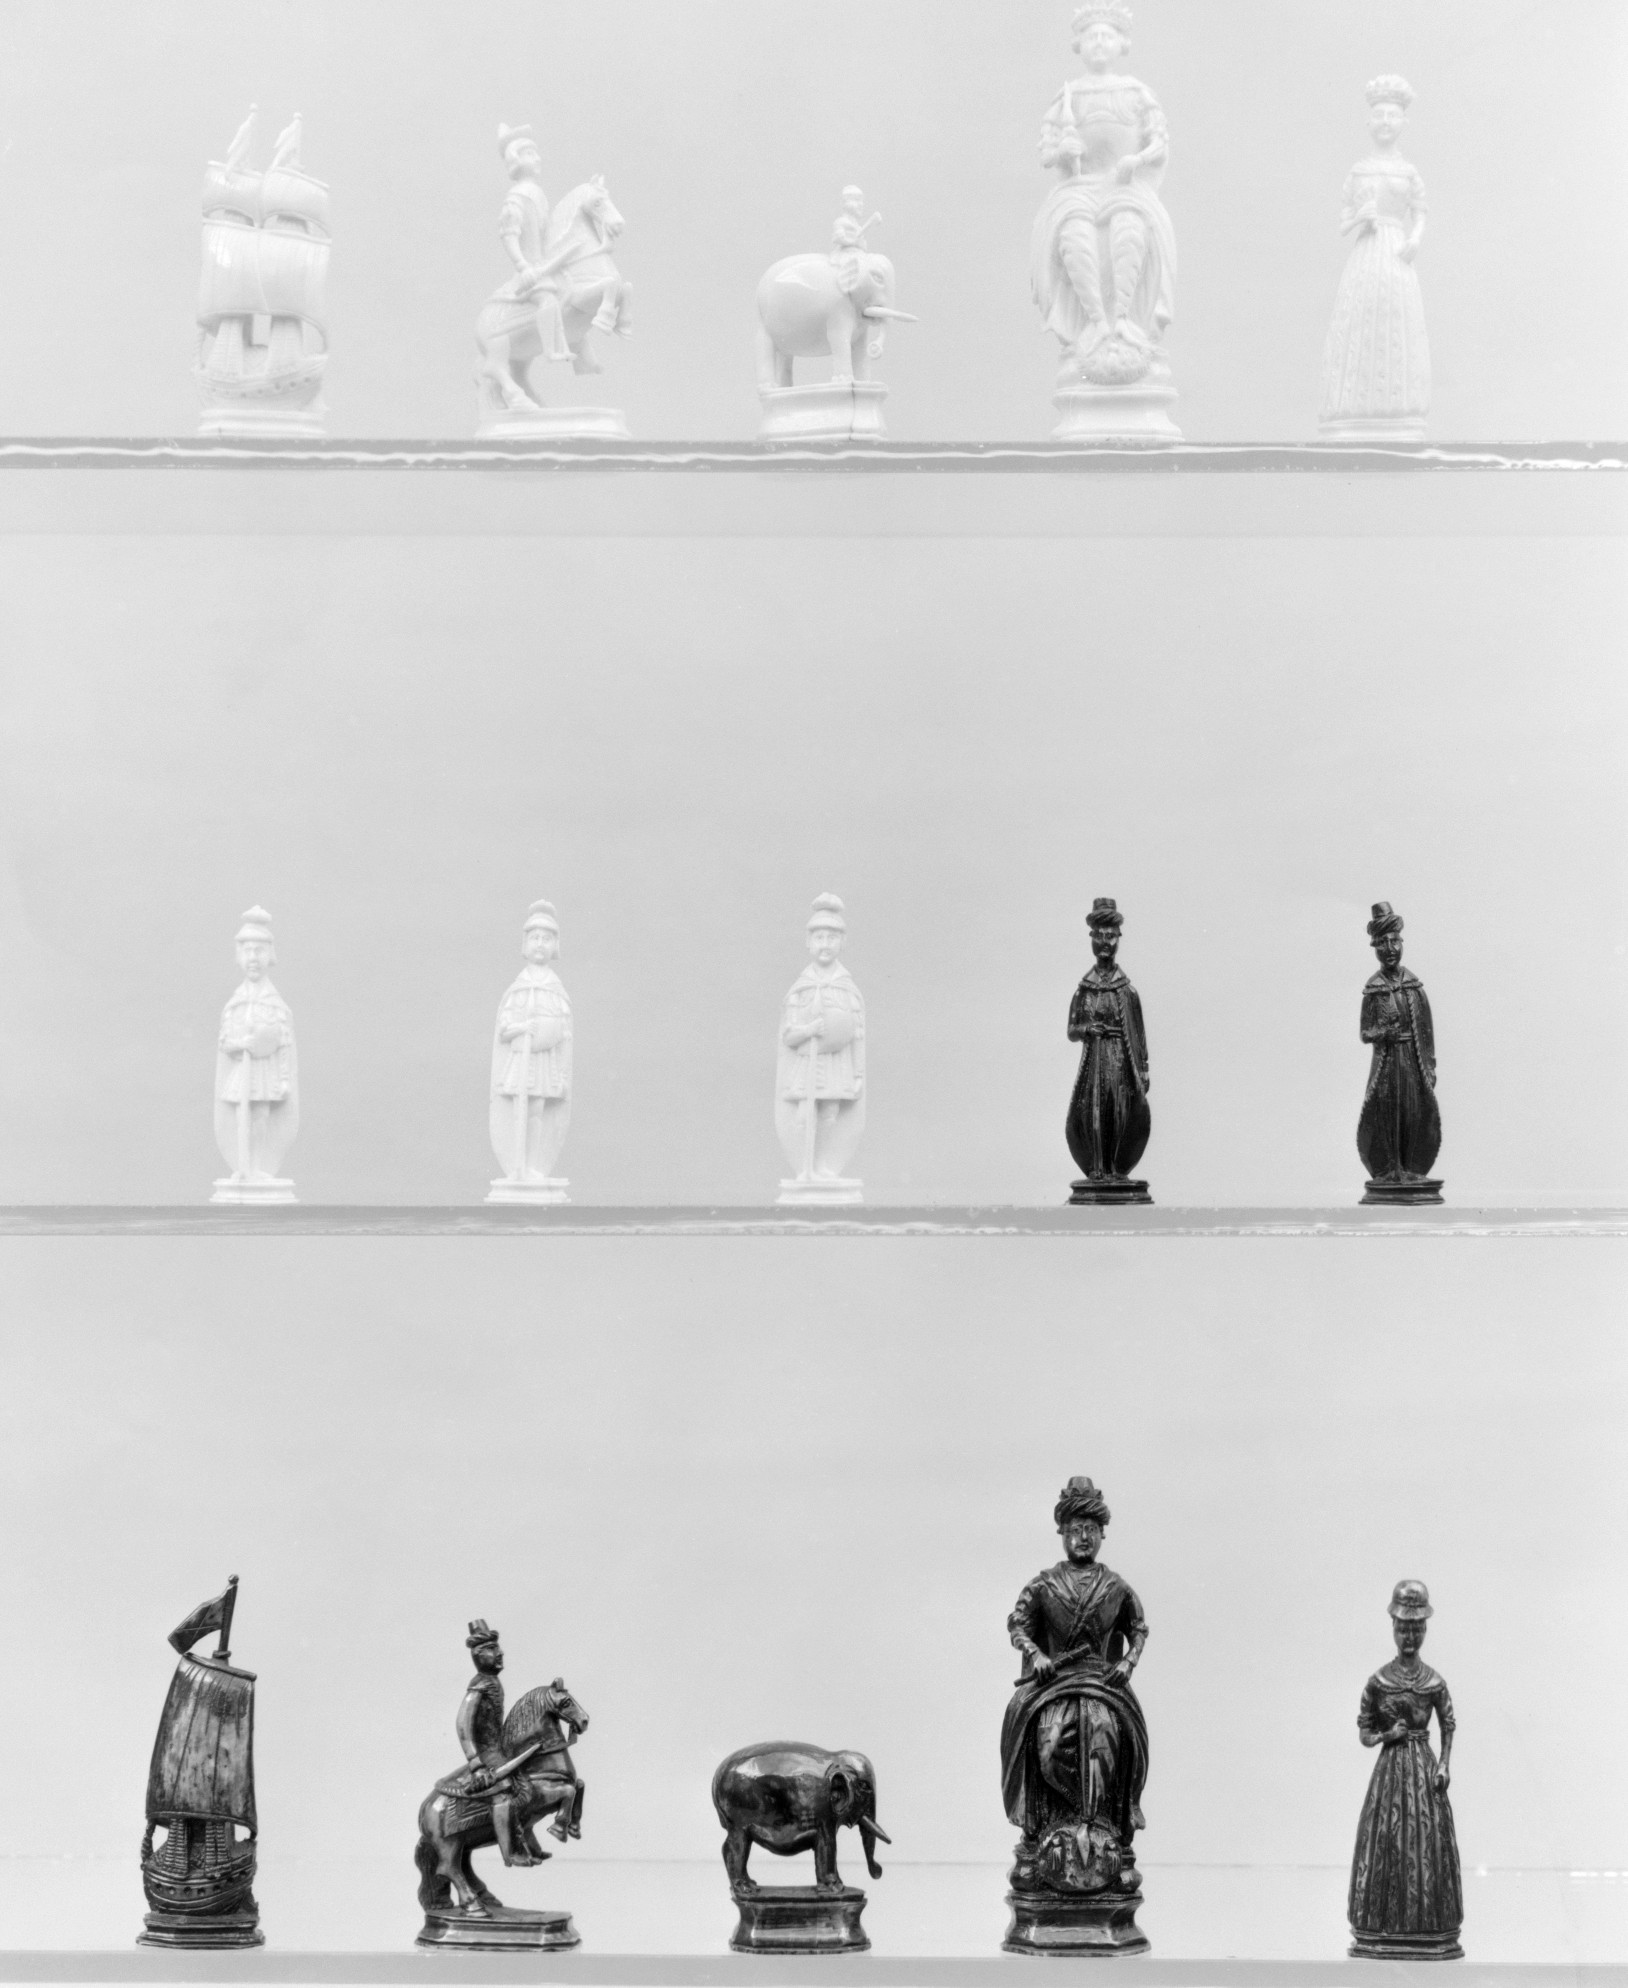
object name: chessman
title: Chessmen (32)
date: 1701-1900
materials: ivory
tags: chess,games